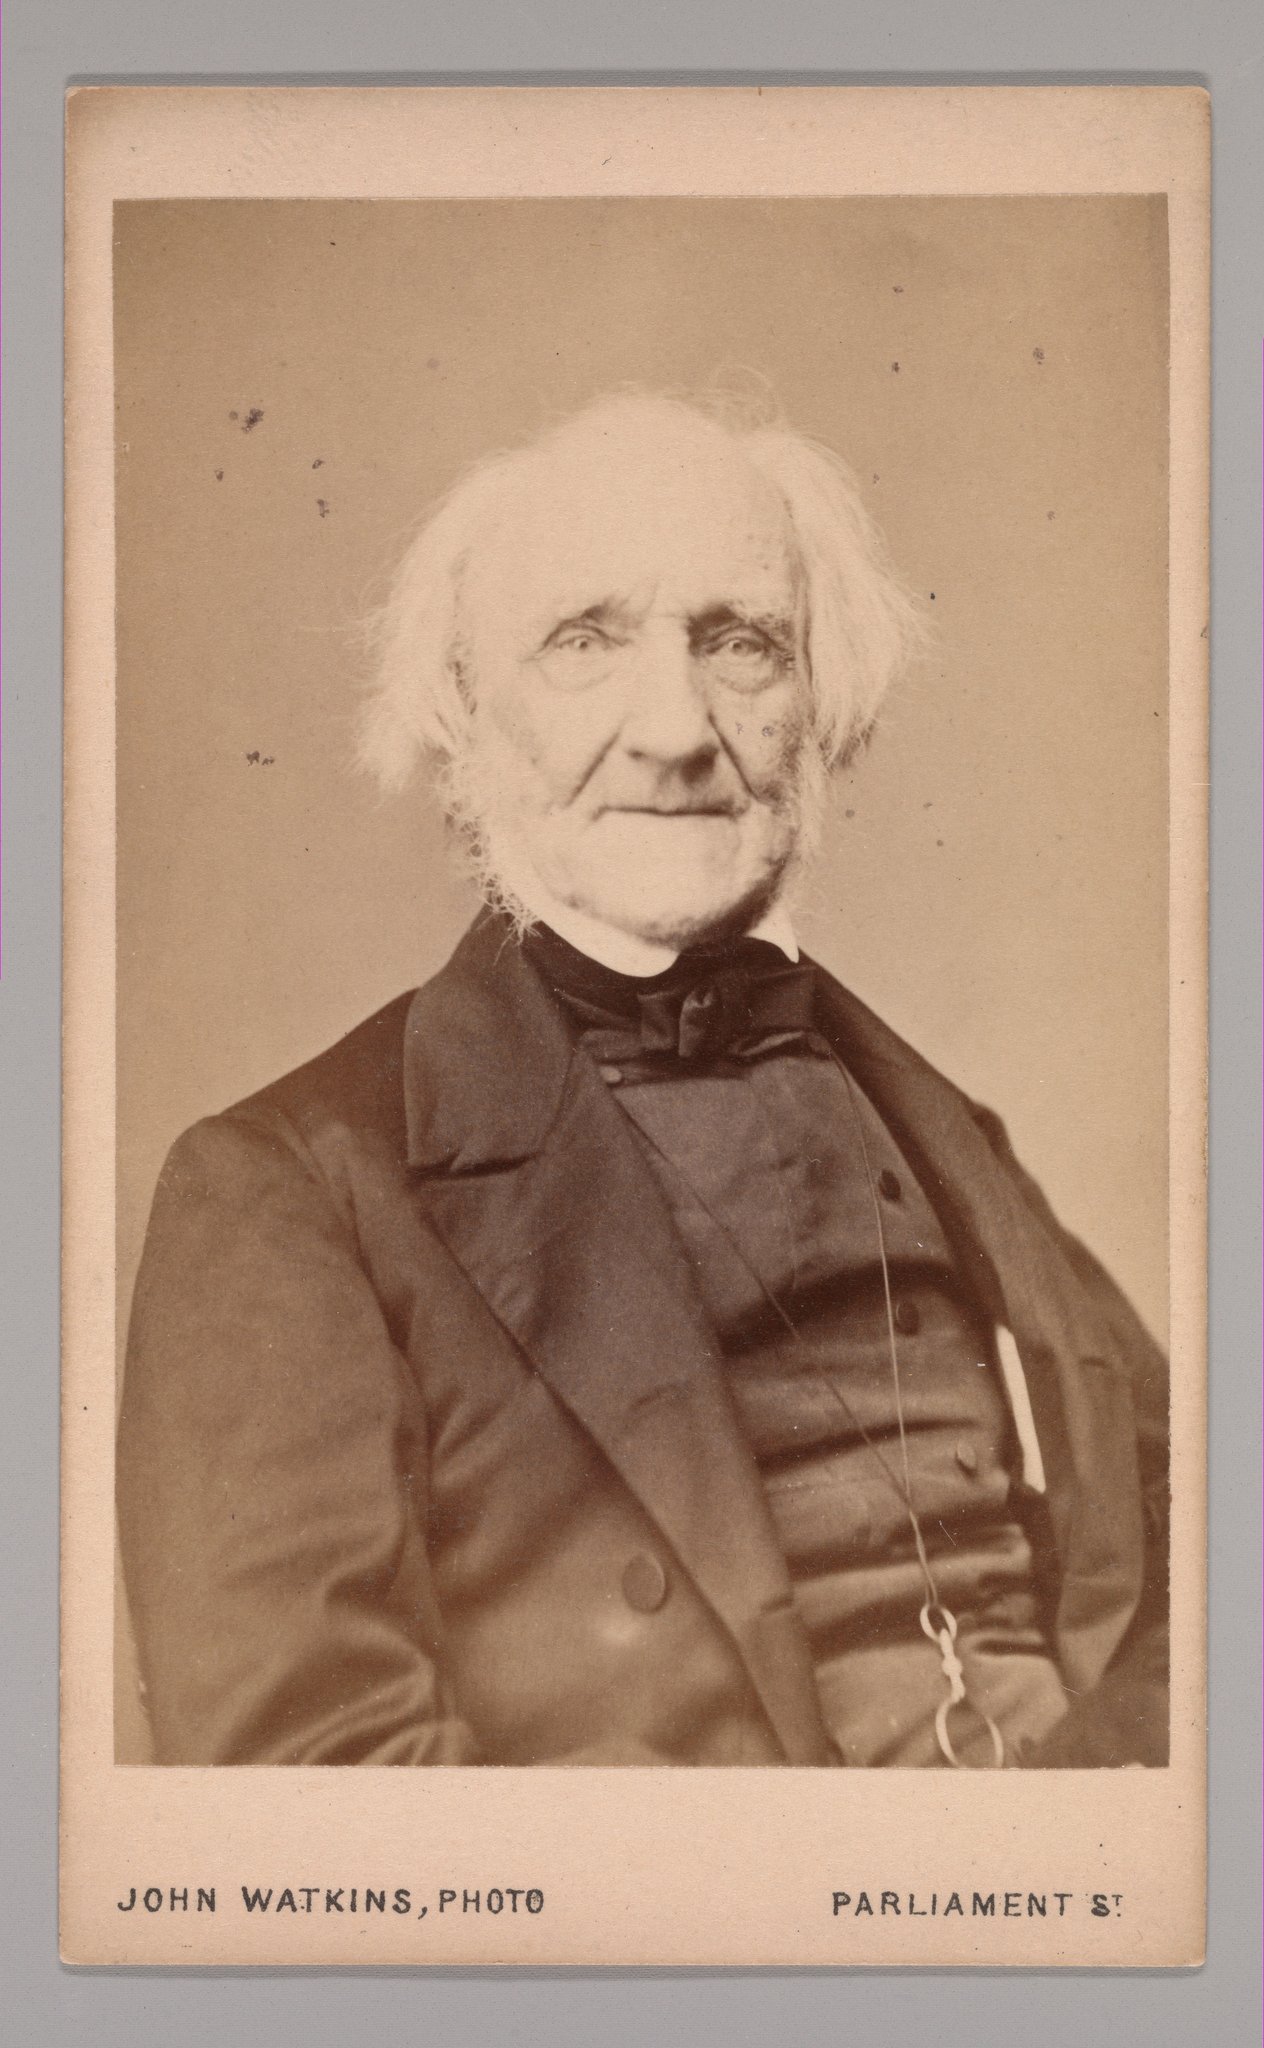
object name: carte de visite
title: [Unknown Subject]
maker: john and charles watkins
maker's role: photography studio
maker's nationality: british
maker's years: 1840-1875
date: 1860-1869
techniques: albumen silver print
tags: men,portraits